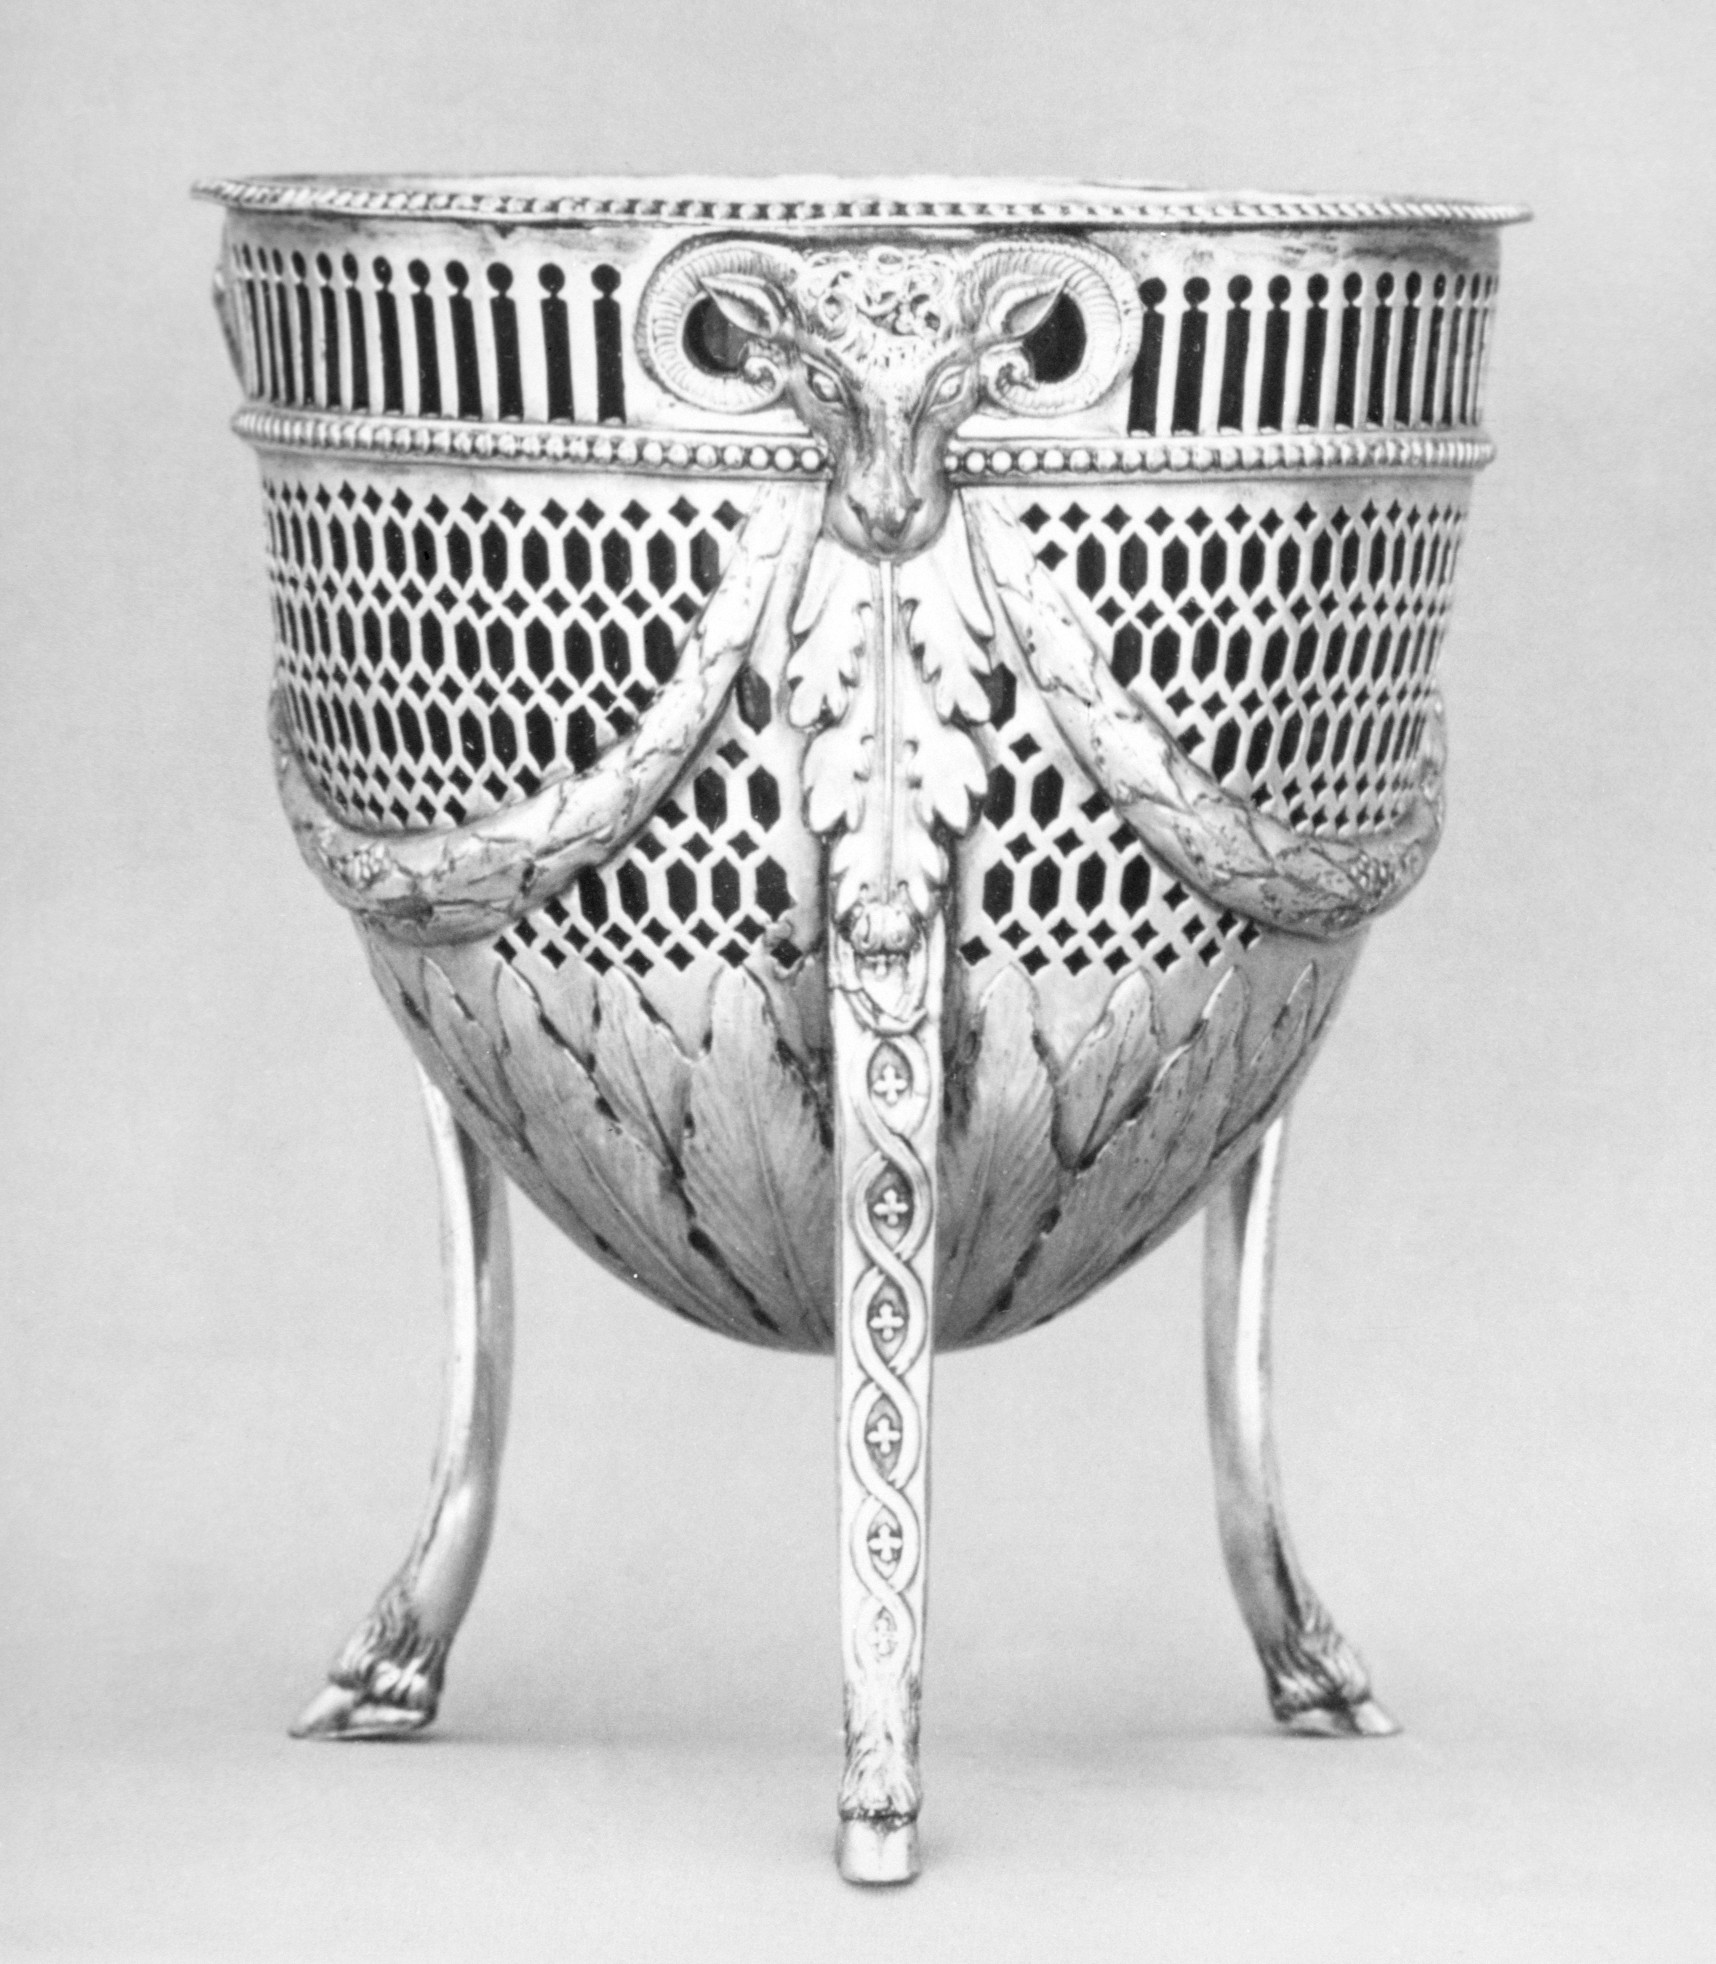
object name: sugar bowl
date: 1775-1785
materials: metal